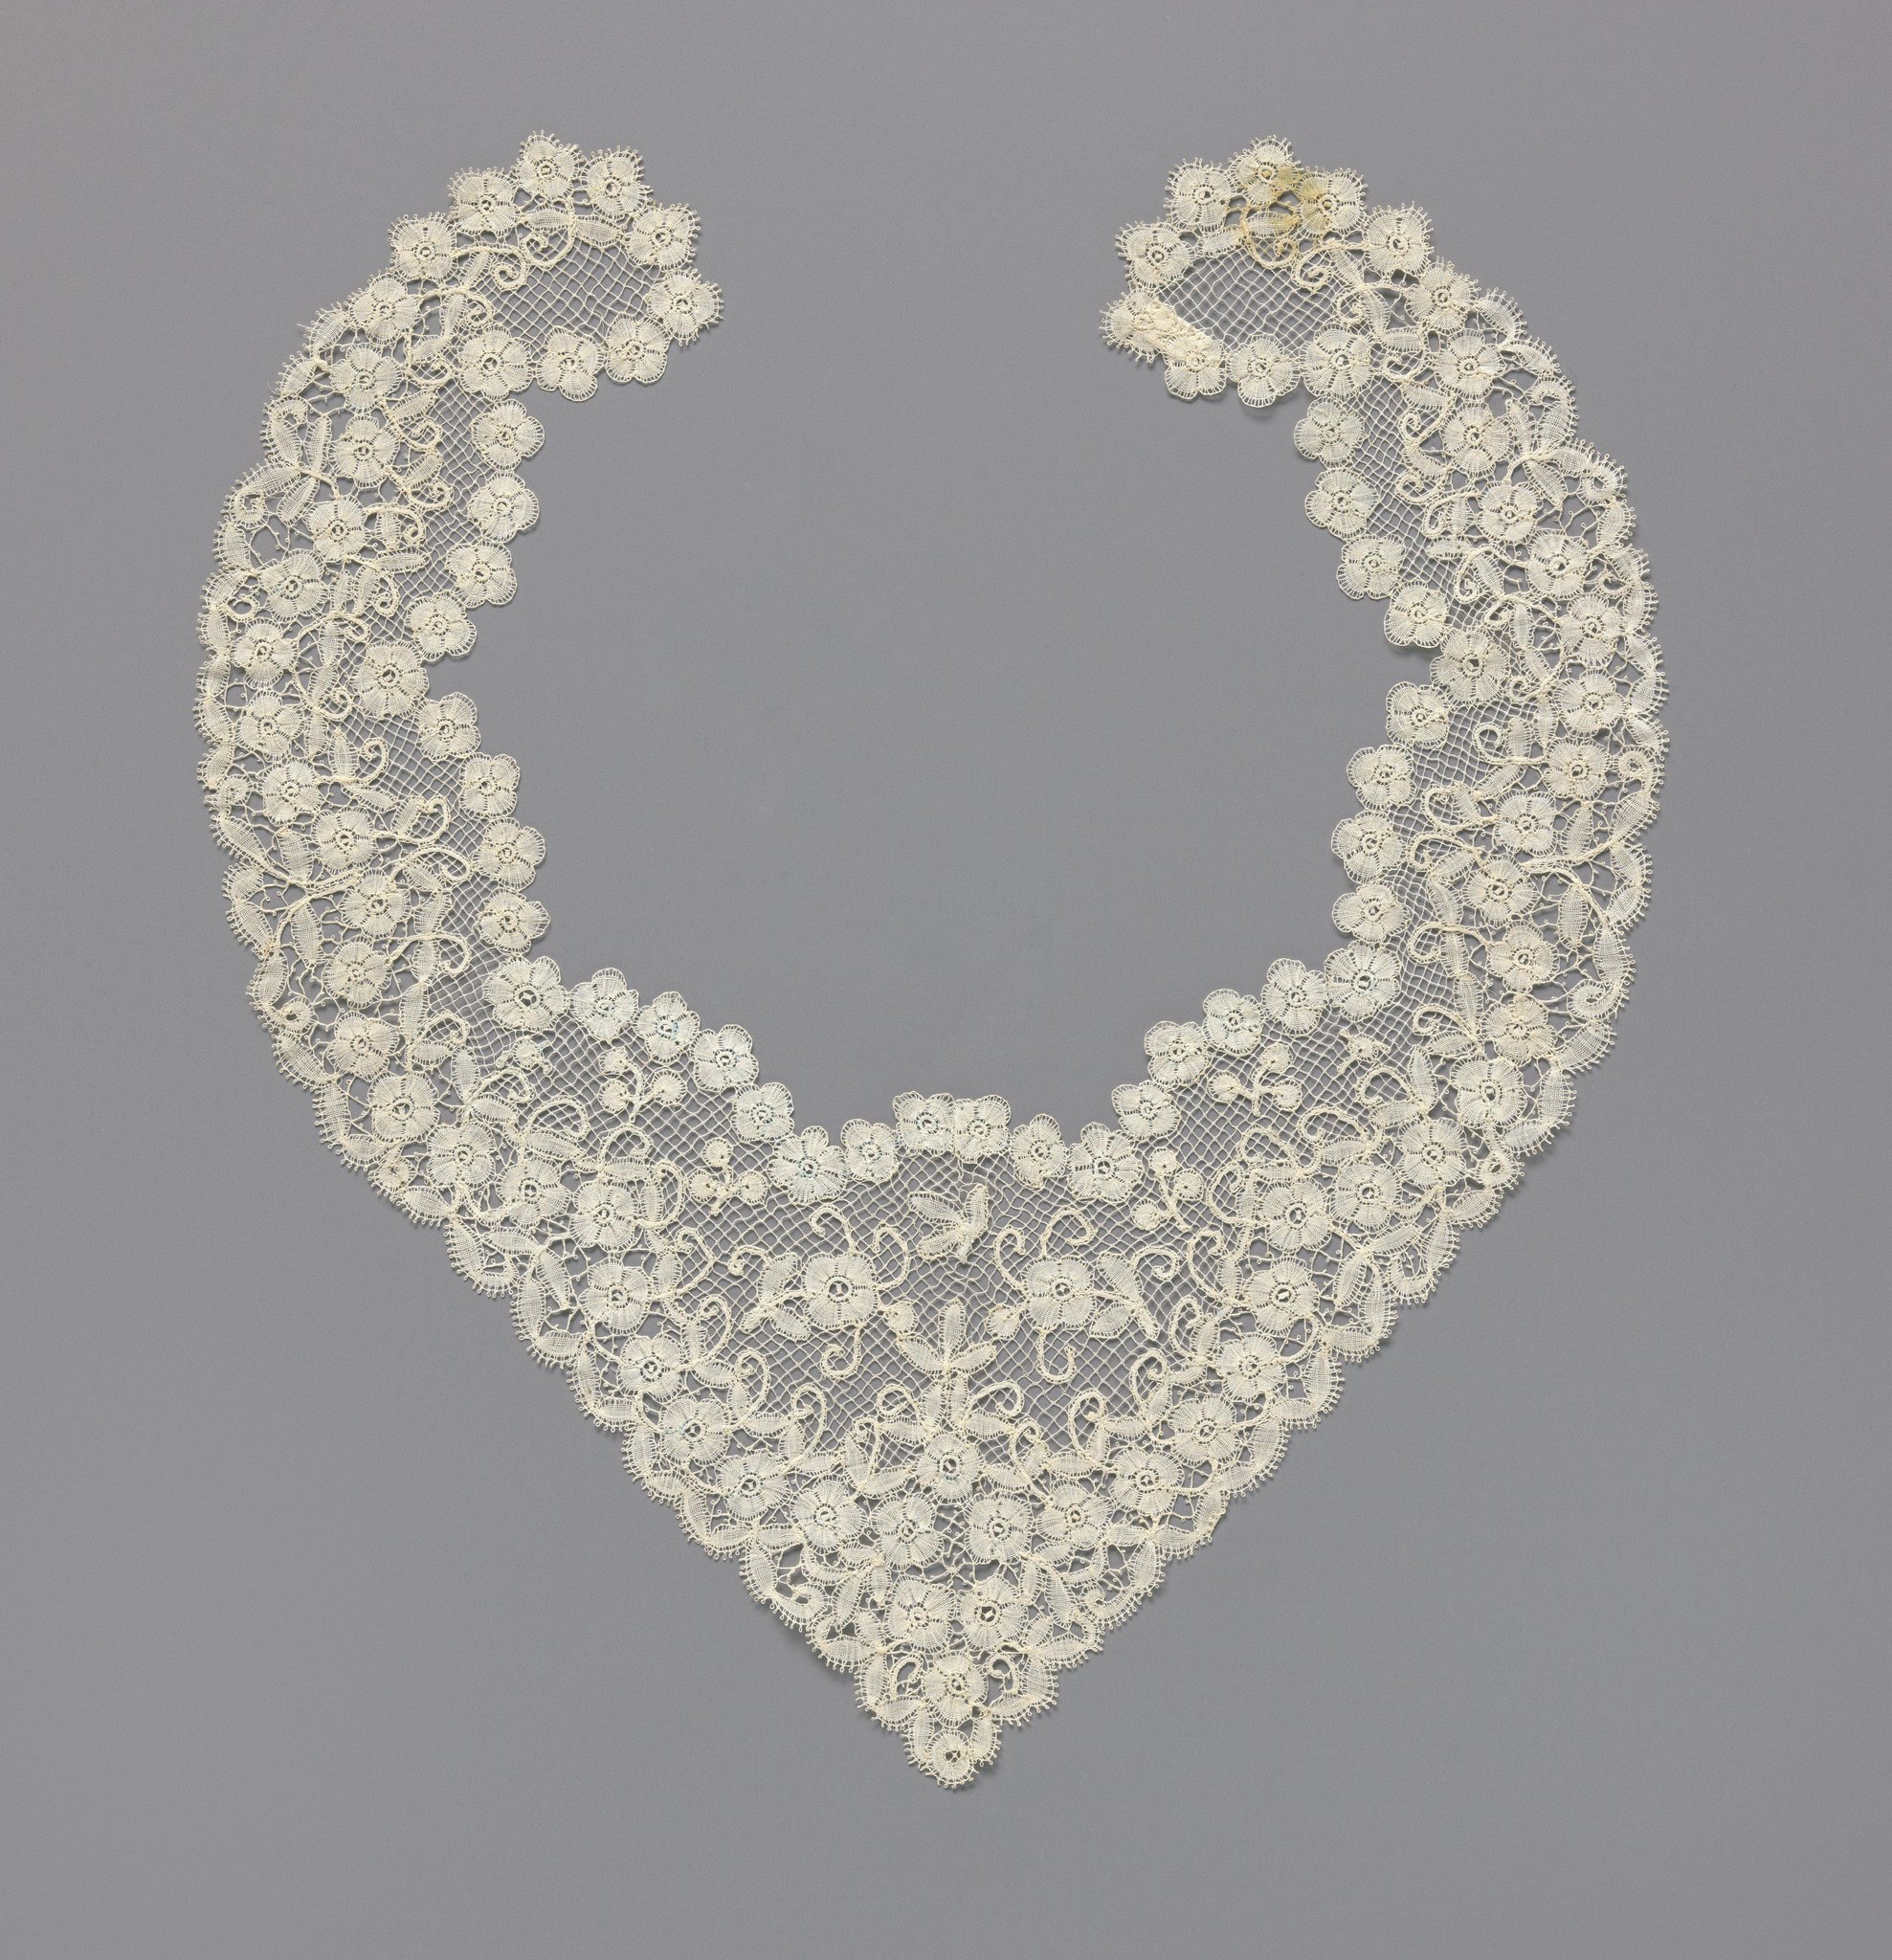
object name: modesty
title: Modestie van kloskant met boterbloempjes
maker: Anonymous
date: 1910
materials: linen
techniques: lace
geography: the hague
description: Guimpe van naturelkleurige kloskant, fijn Brugs bloemwerk. Het guimpje is rechthoekig met verbrede uiteinden. De achtergrond, half in mazen, half in spijlen, is door een boogjeslijst verdeeld. Op de mazen staan enige los gestrooide takjes met besjes en een randje van 'boterbloempjes' aan stengeltjes.